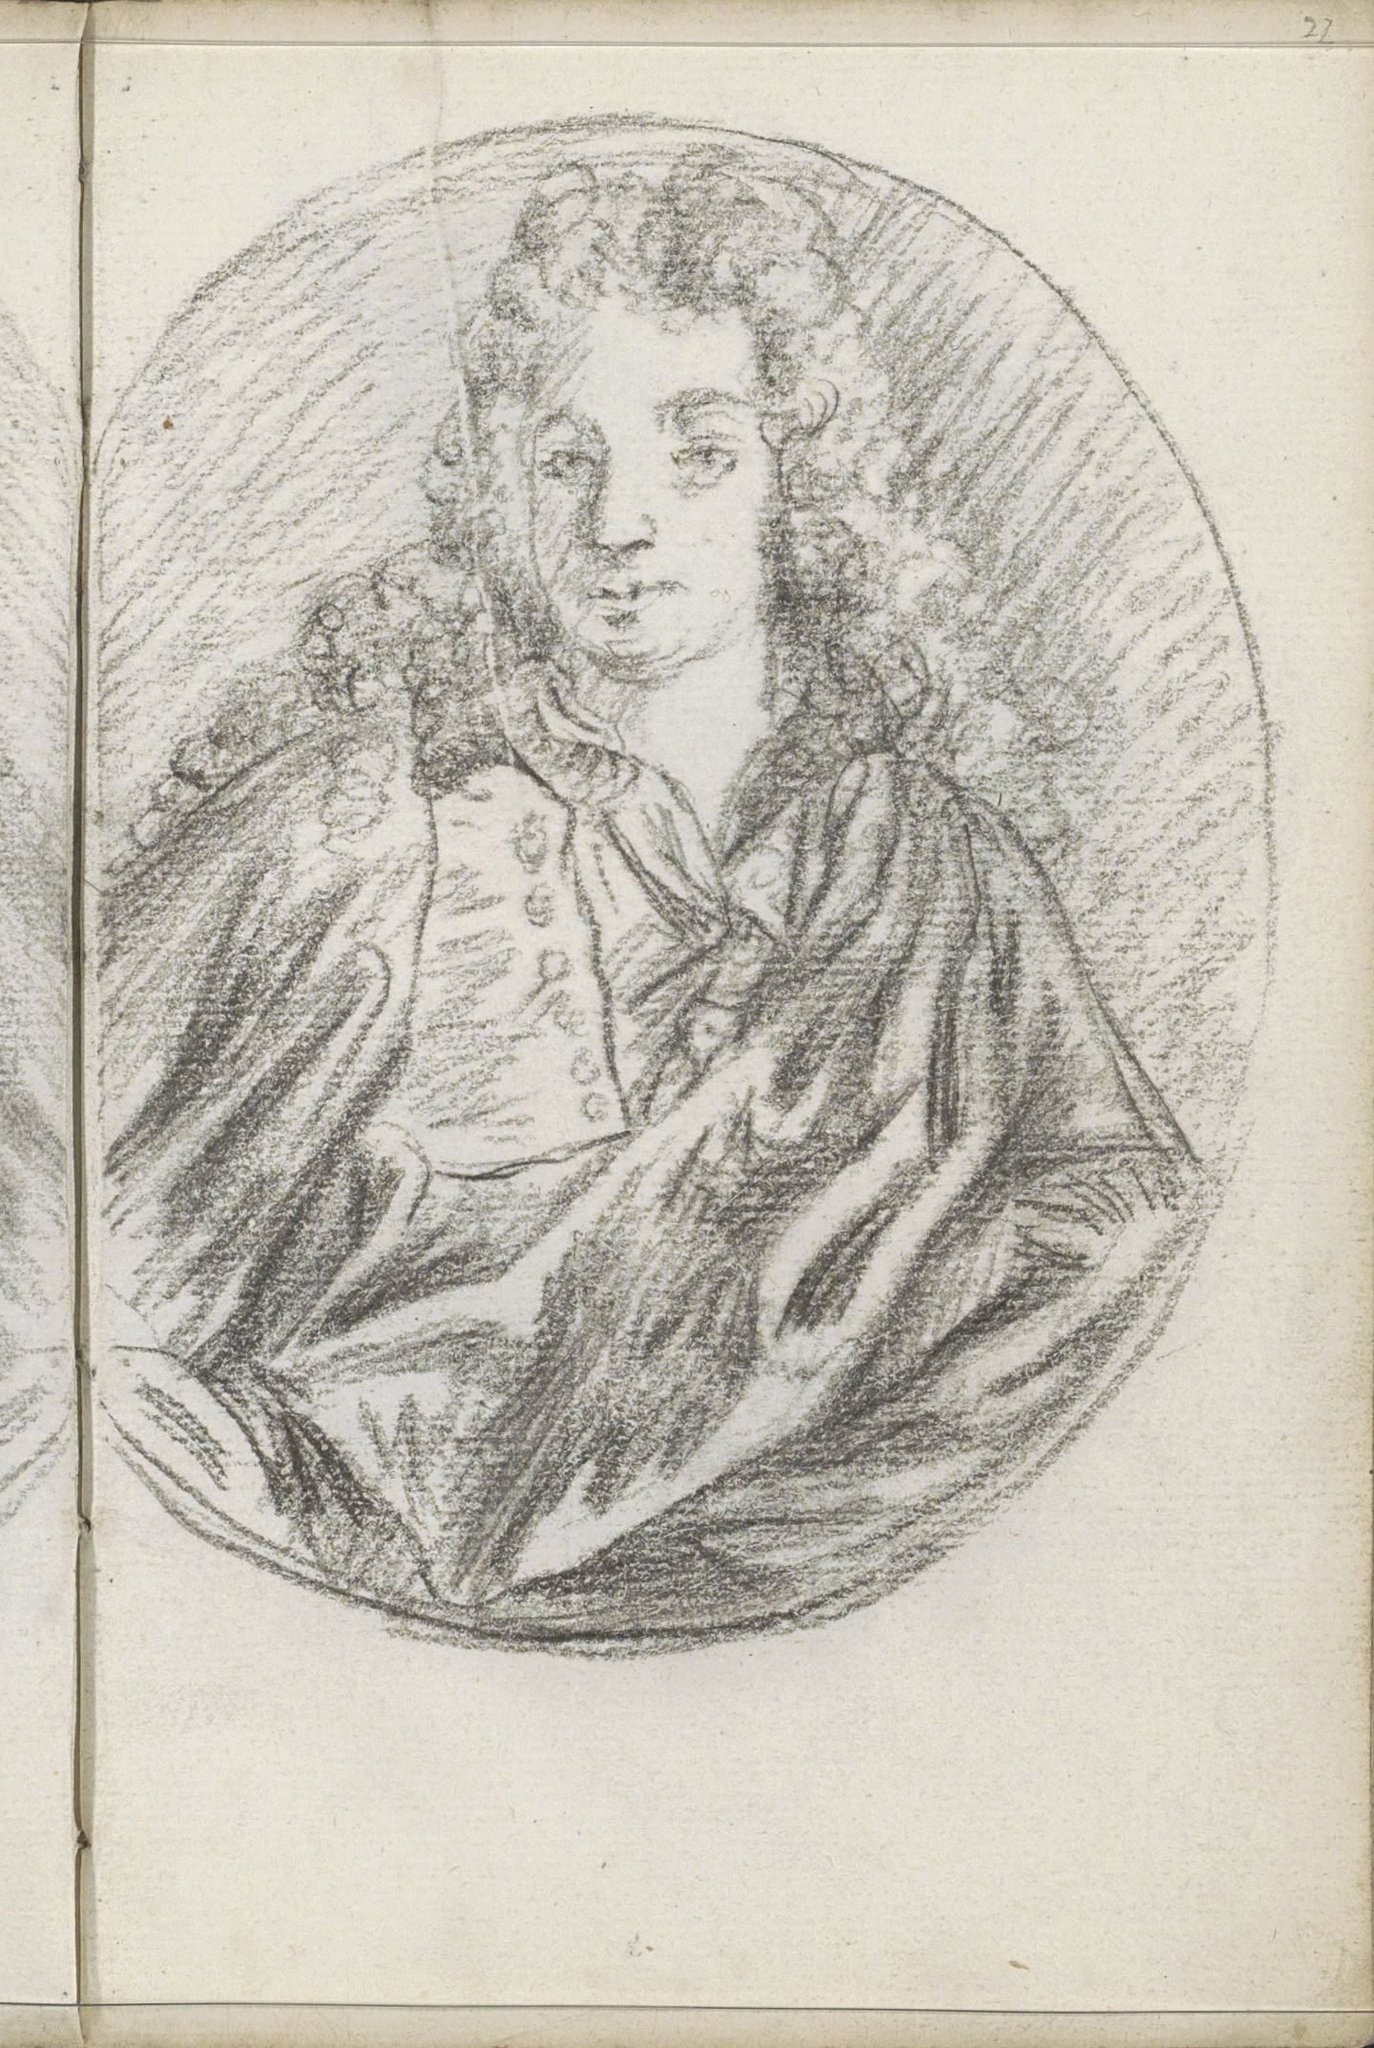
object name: sketchbook leaf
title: Portret van een man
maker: petrus johannes van reysschoot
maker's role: draughtsman, print maker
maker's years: 1702-1772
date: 1710-1772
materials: chalk, paper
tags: anonymous historical person portrayed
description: Tekening in een ovaal. Blad 22 recto uit een schetsboek met 105 bladen.